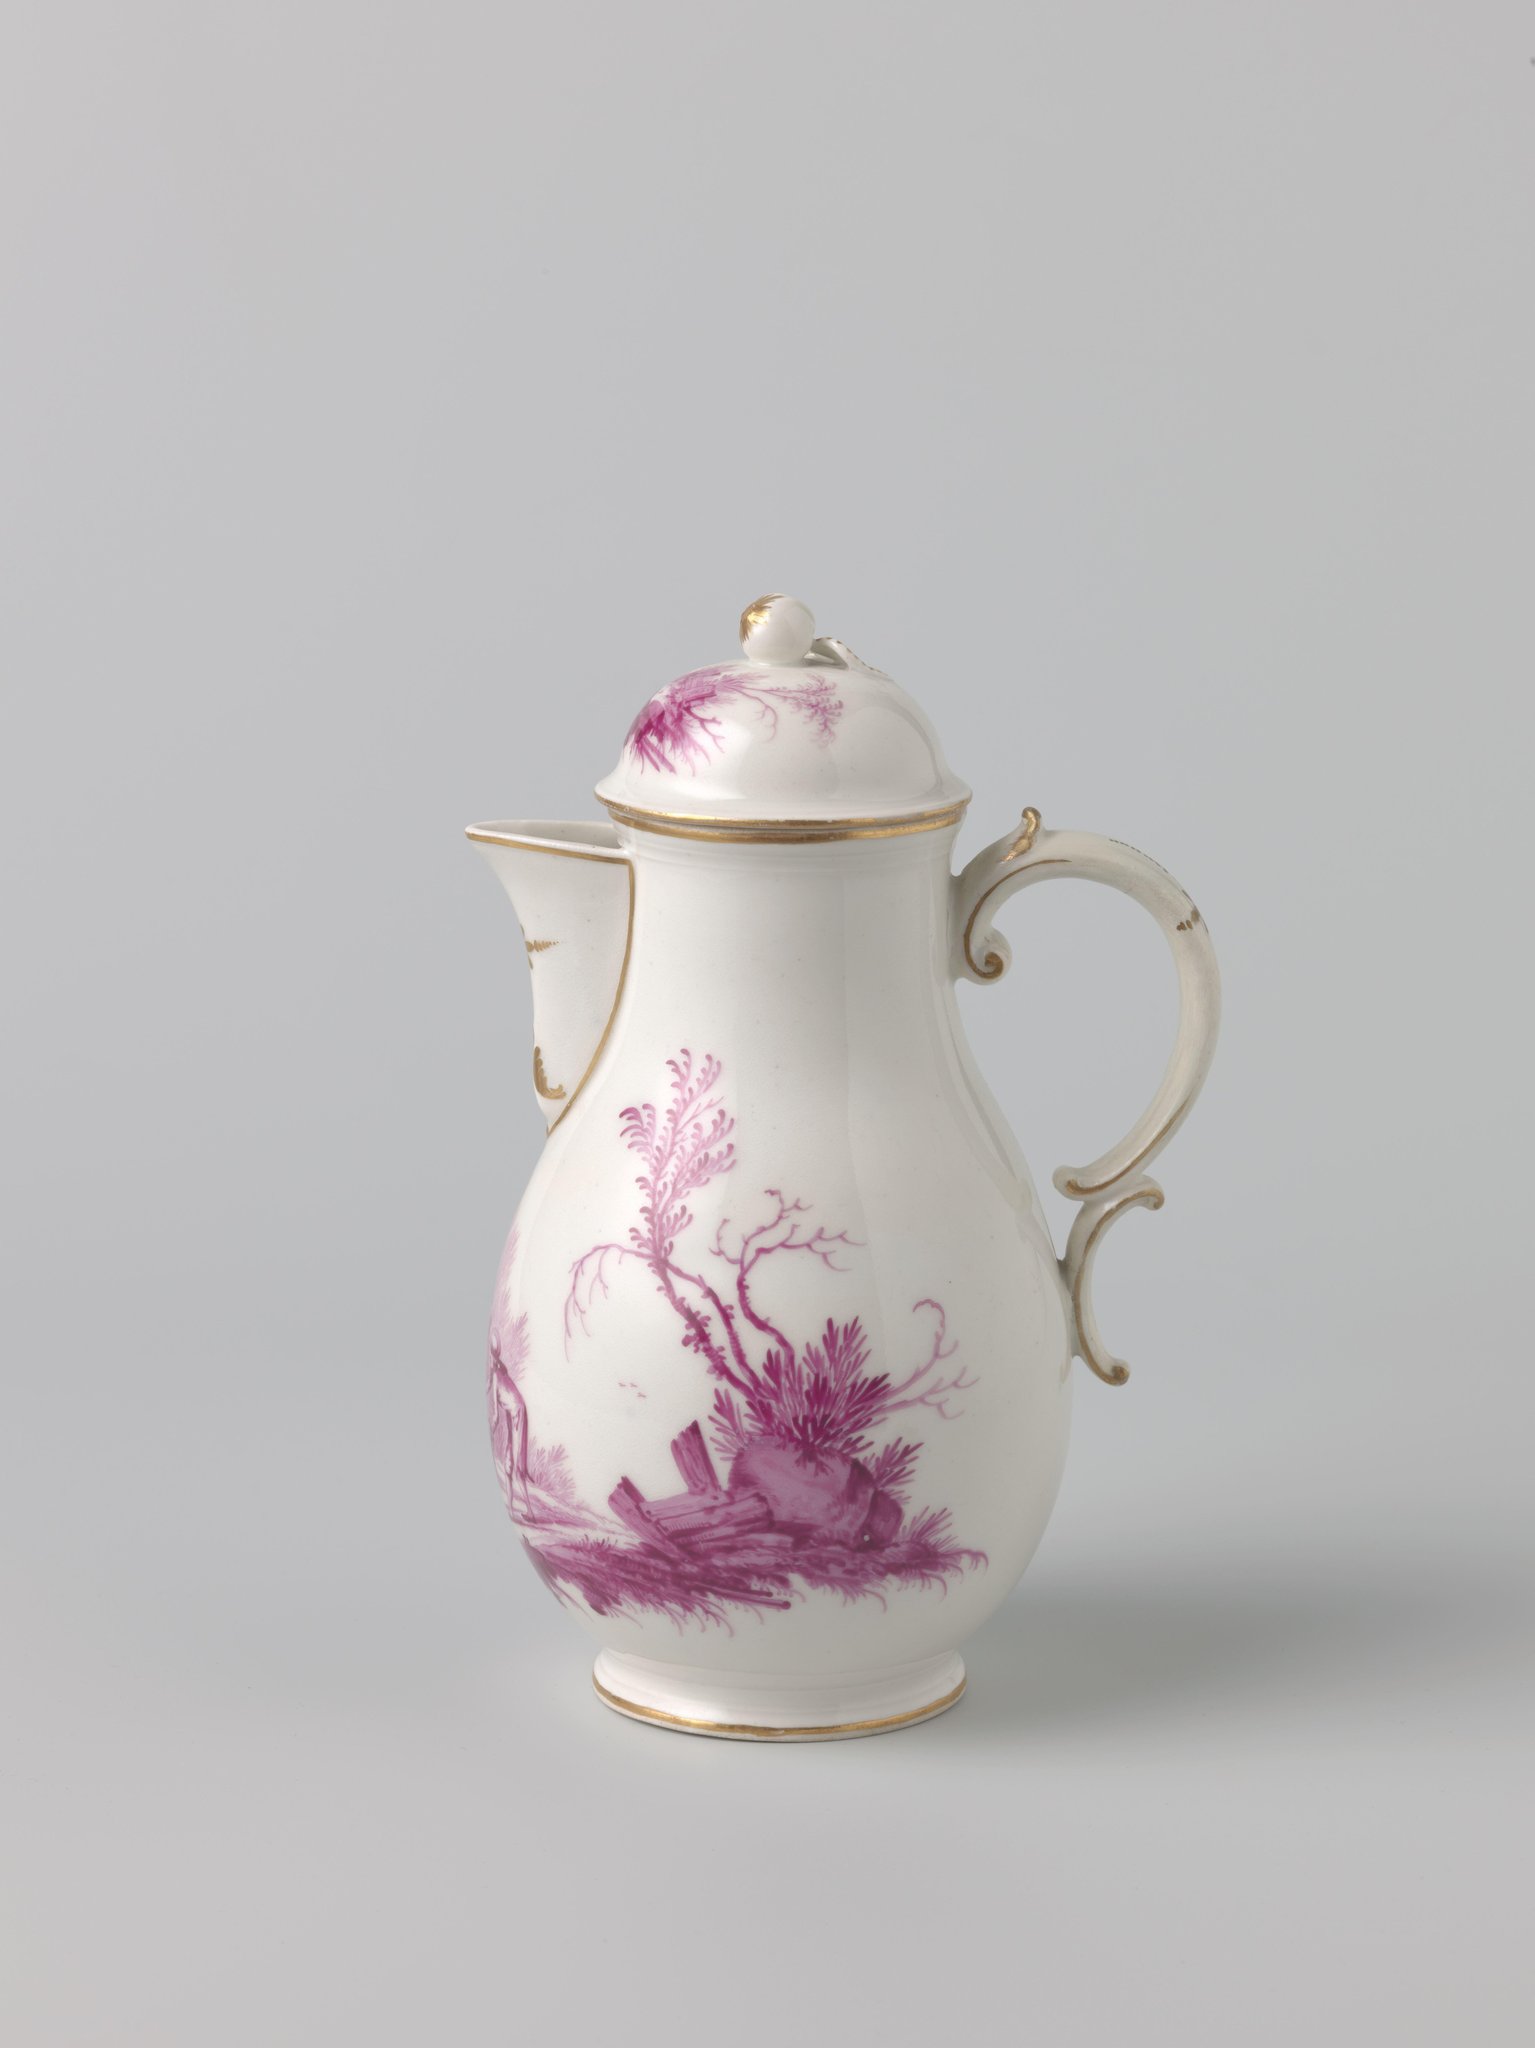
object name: coffee pot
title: Koffiekan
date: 1774-1784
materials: porcelain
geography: loosdrecht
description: Deksel van porselein. Beschilderd in lila met een landschap.